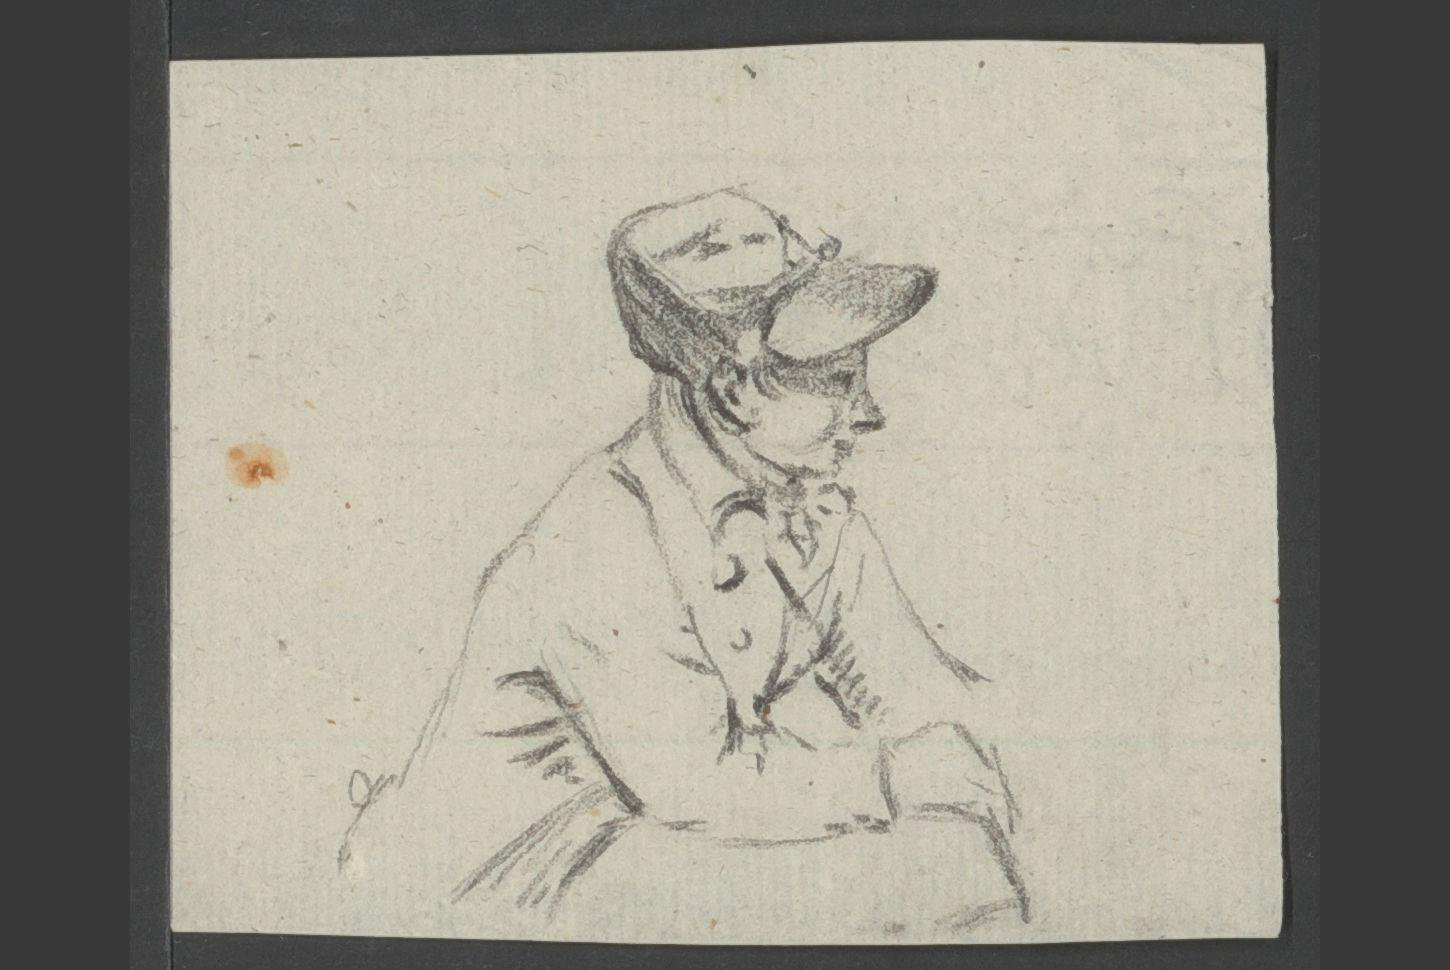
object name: drawing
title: Jongen met pet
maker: Anonymous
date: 1800-1899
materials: chalk, paper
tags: boy (child between toddler and youth), head-gear: cap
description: Onderwerpsrubrieken binnen de Atlas Zeden en Gewoonten: Schoone kunsten, Schilderkunst, Tekeningen.